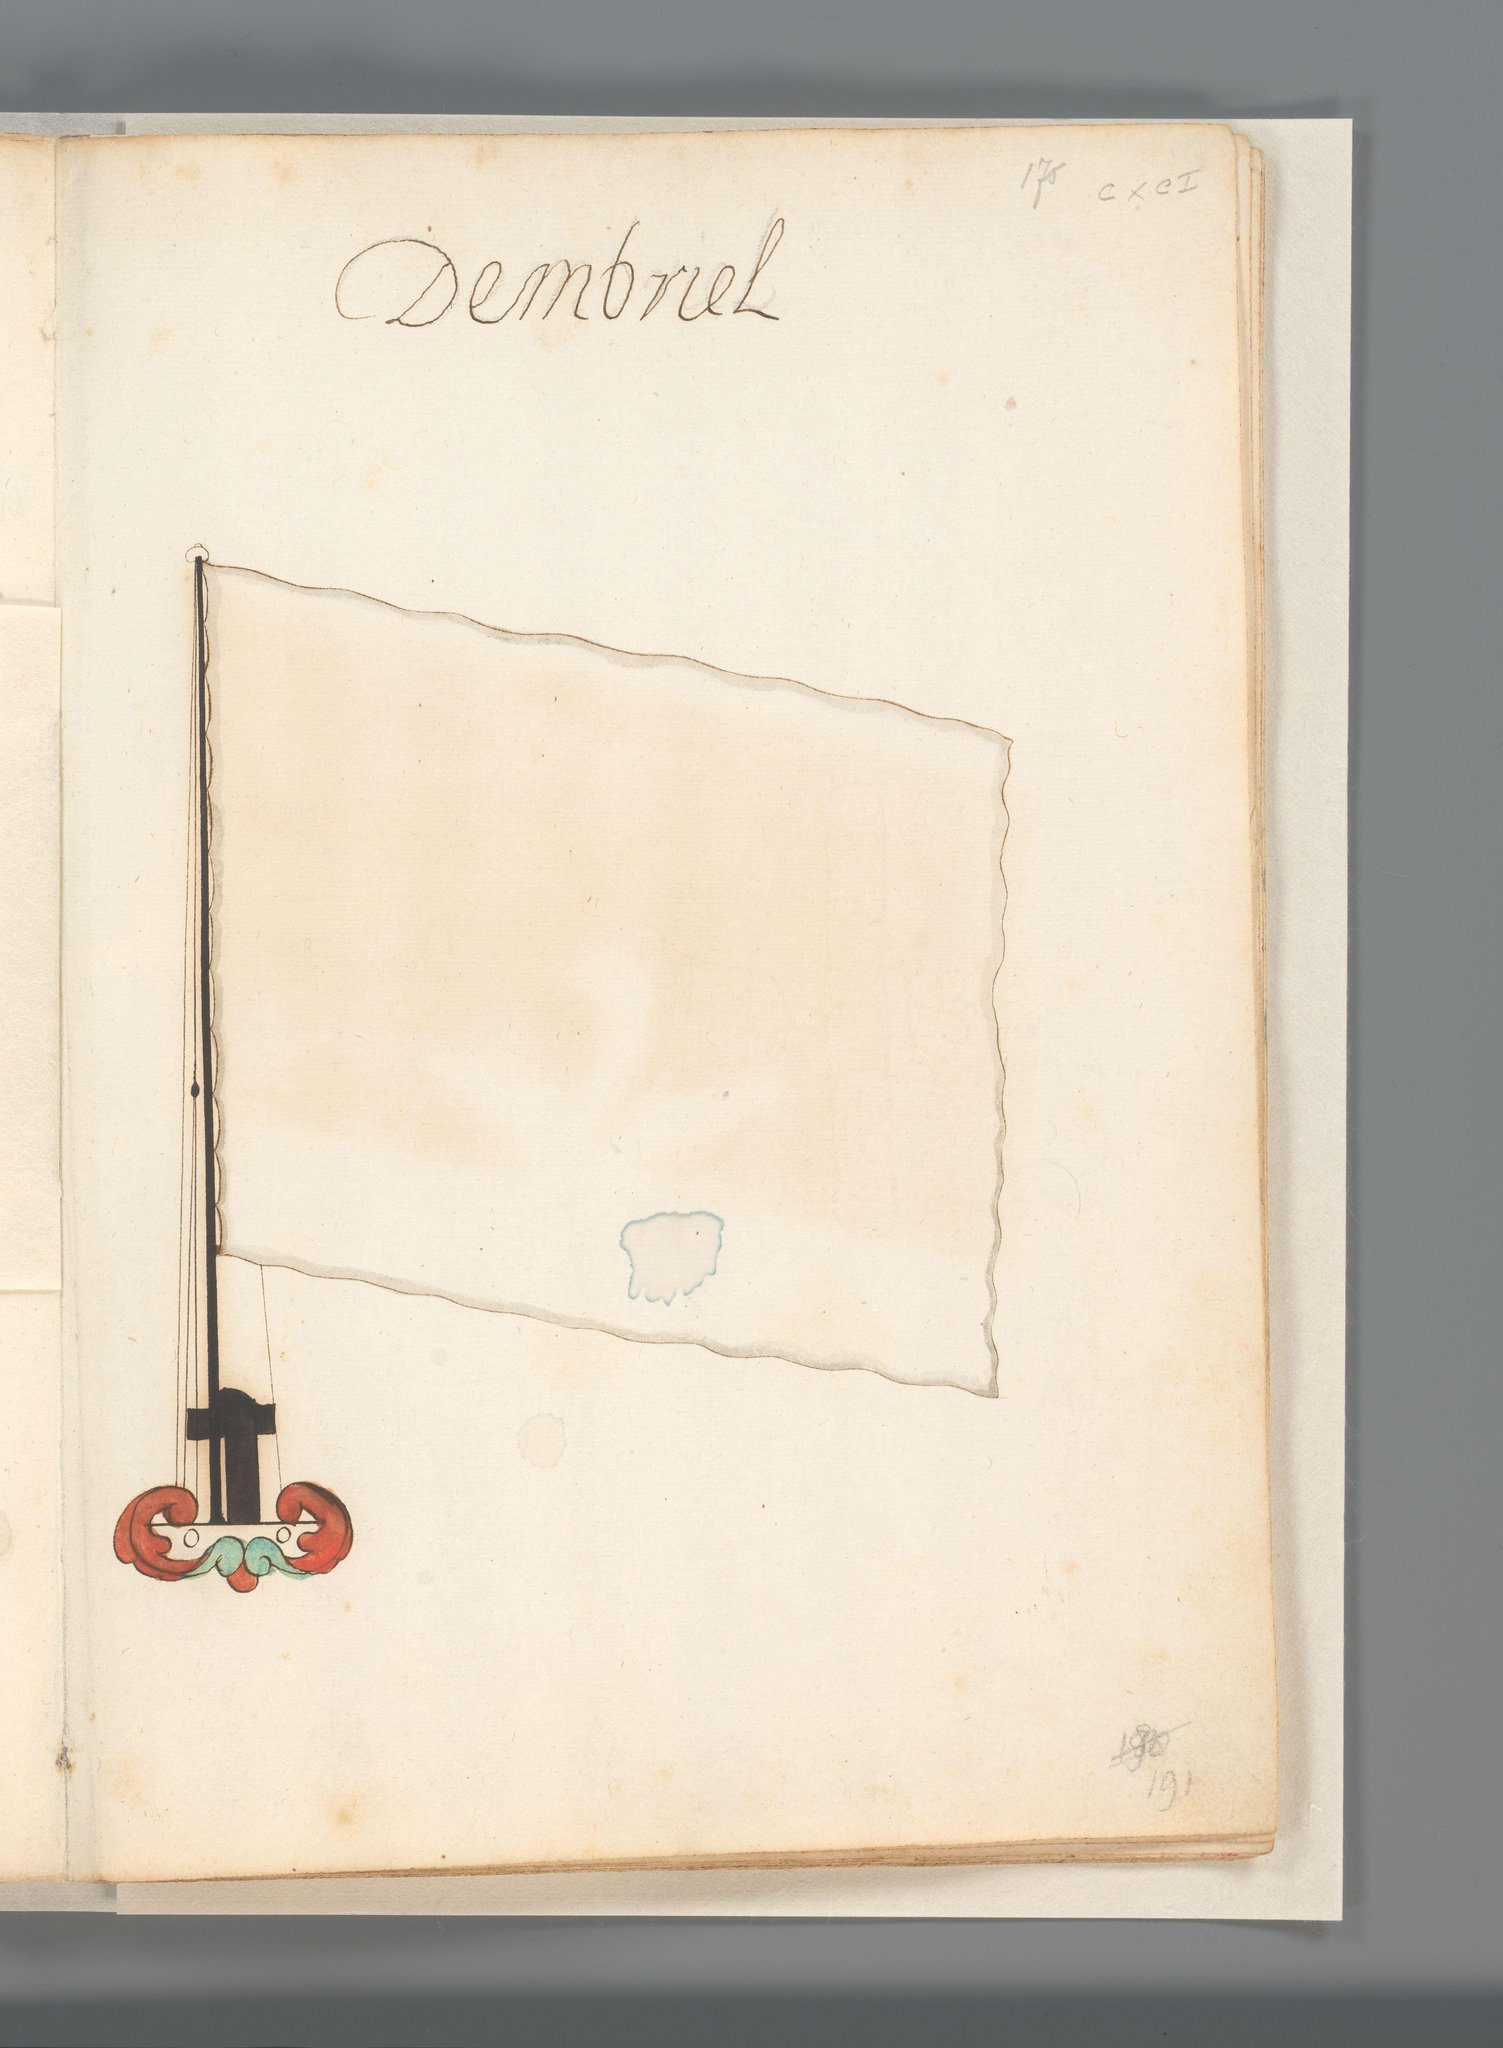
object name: drawing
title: Vlag van Brielle (blanco)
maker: Anonymous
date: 1667-1670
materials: ink, paper, watercolor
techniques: brush, pen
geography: france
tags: flag, colours (as symbol of the state, etc.), brielle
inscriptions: number: ‘175 / CXCI / 191’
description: Blanco, oningevulde vlag, bestemd voor de vlag van de stad Brielle (Den Briel). Vlag op vlaggensteng en mastvoet. Afgebeeld op folio 96r. Onderdeel van een vlaggenboek met vlaggen uit Europa, Noord-Afrika, Nabije en Verre Oosten.